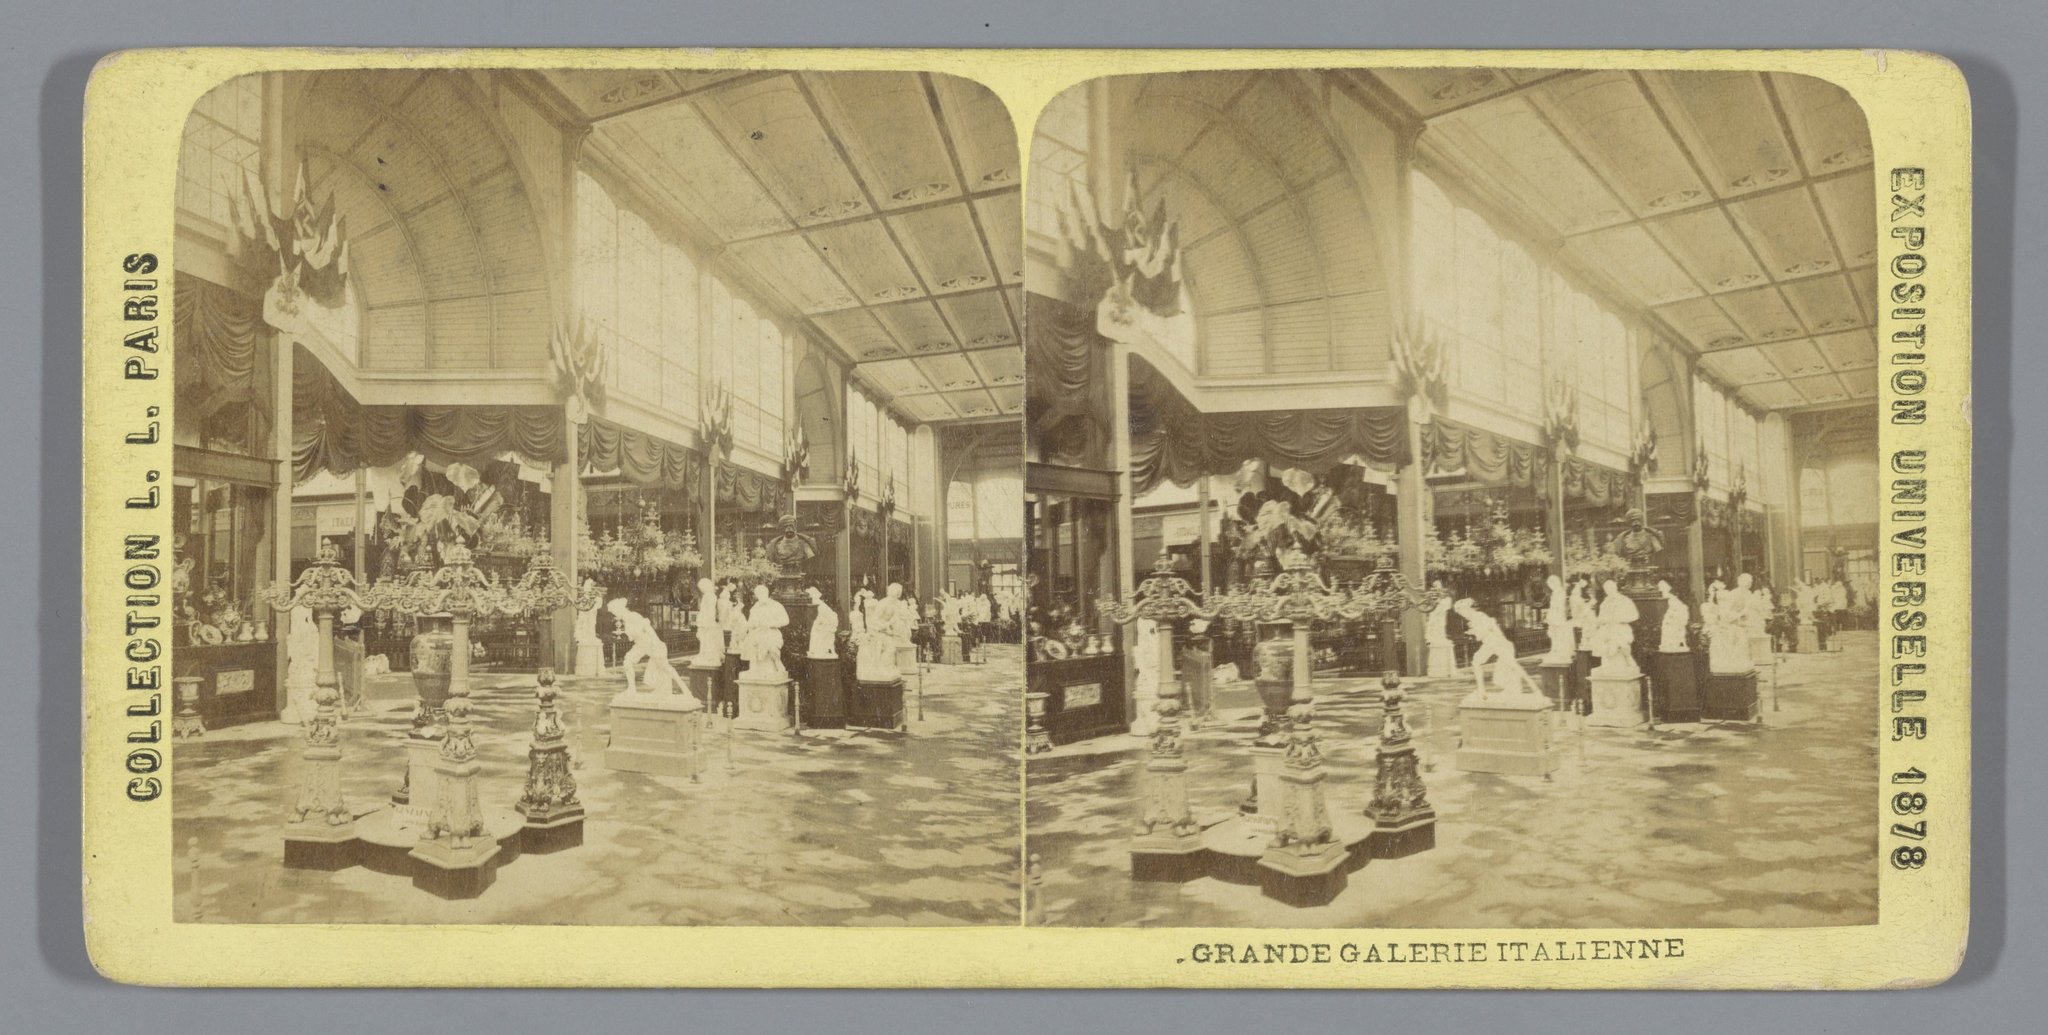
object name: stereograph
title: Exposition Universelle 1878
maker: Anonymous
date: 1878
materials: cardboard, paper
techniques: albumen print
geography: paris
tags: world fair, world exhibition, gallery (spacious corridor), paris